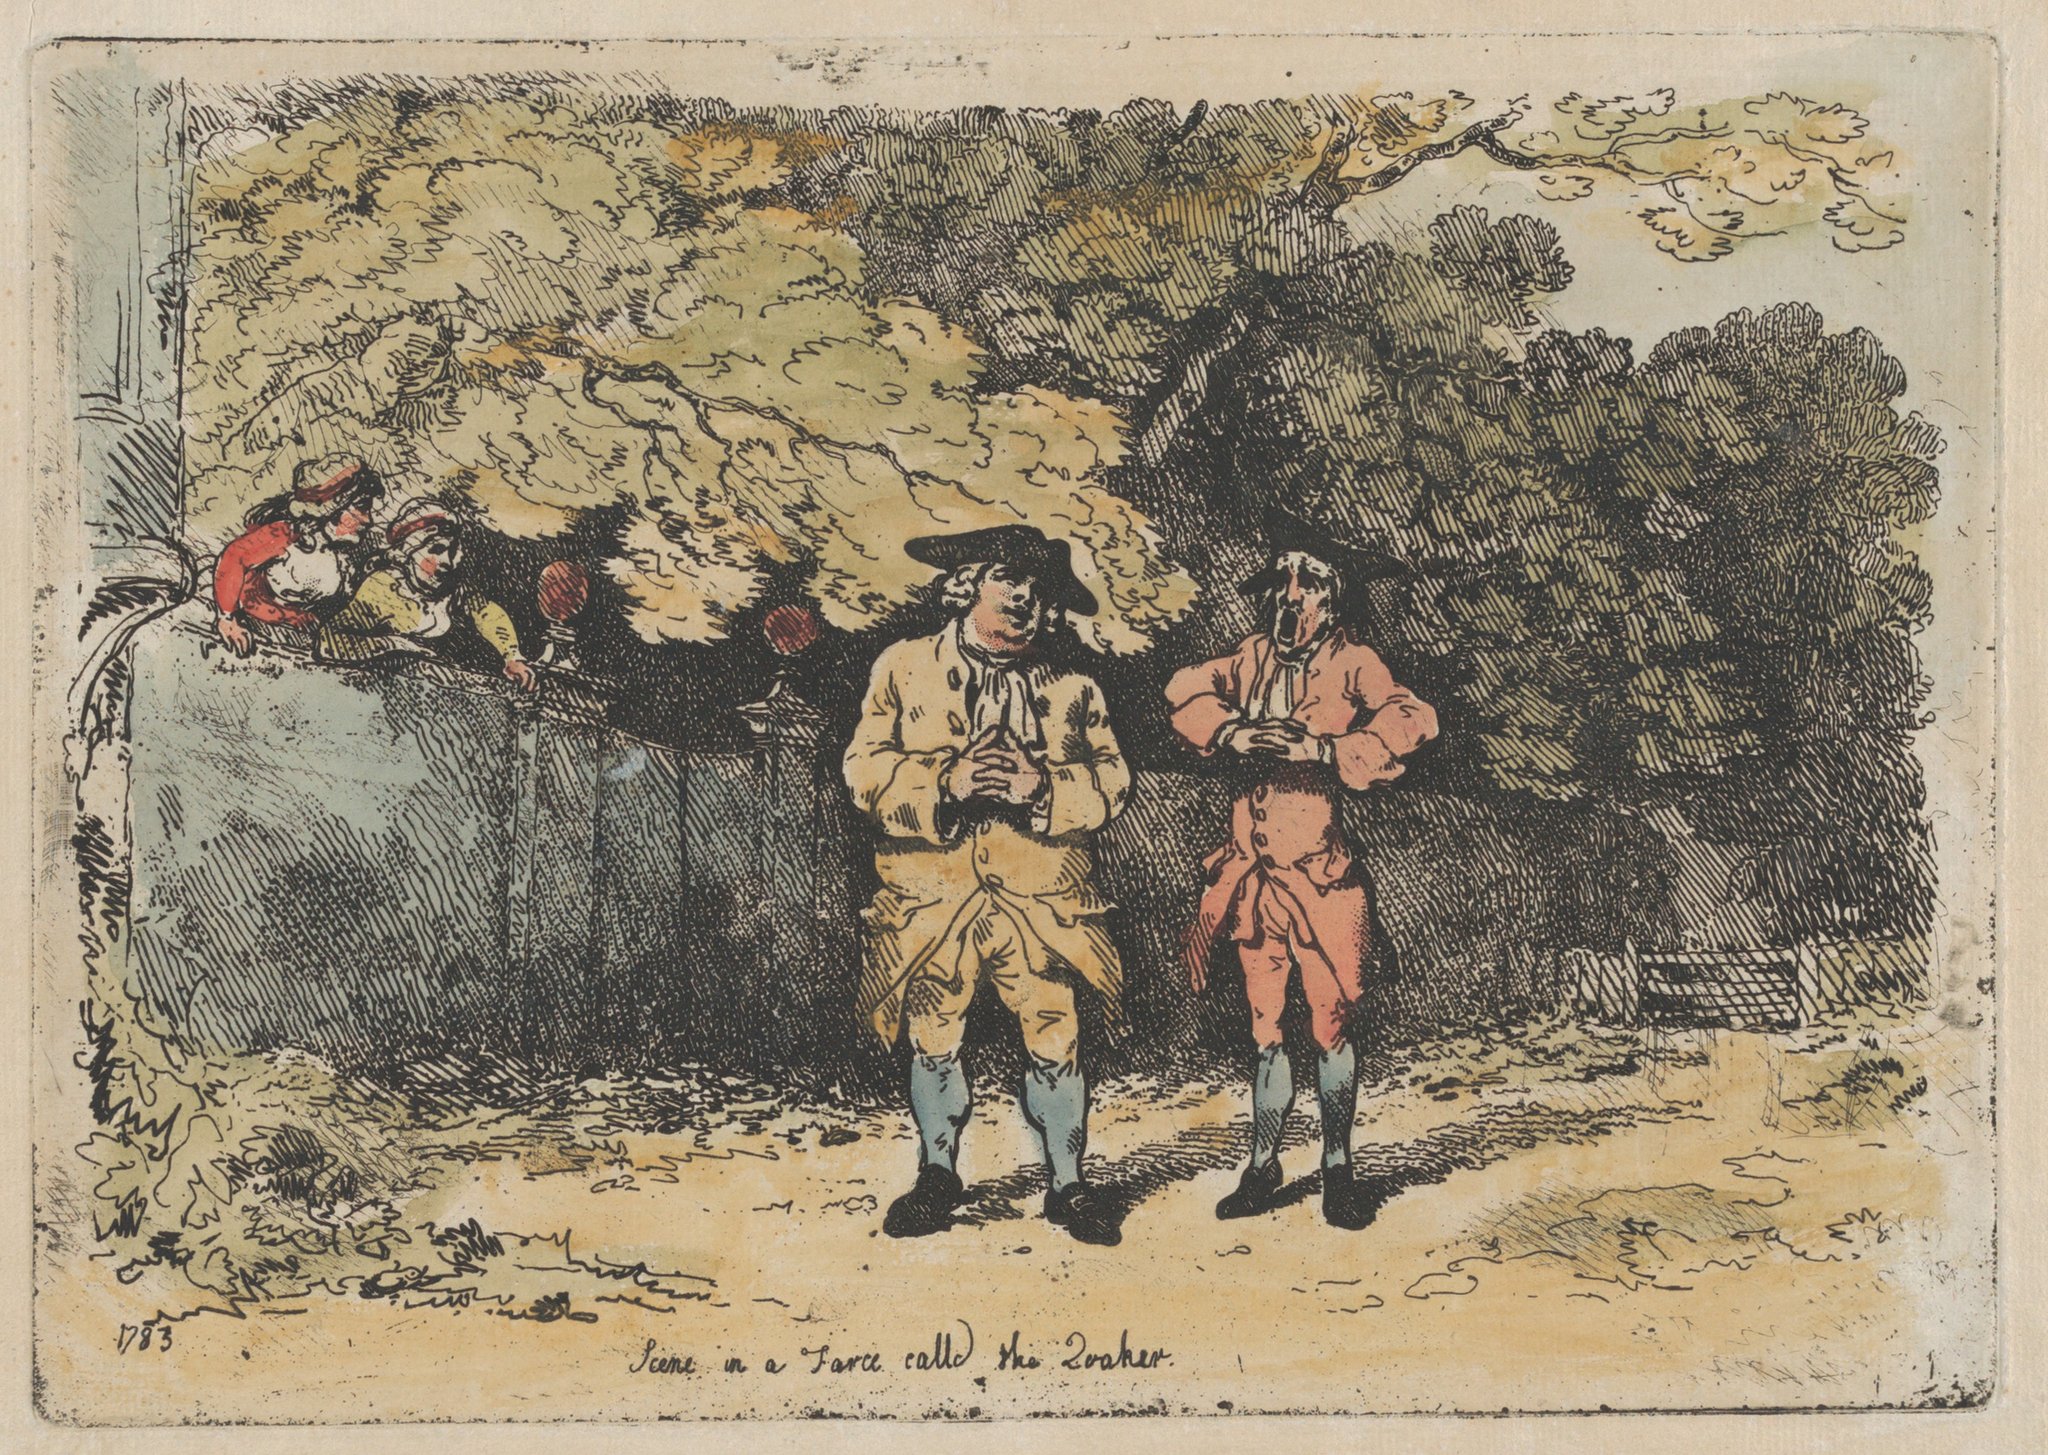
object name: print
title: Scene in a Farce called The Quaker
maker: thomas rowlandson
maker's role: artist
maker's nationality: british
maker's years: 1757-1827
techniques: etching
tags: opera,men